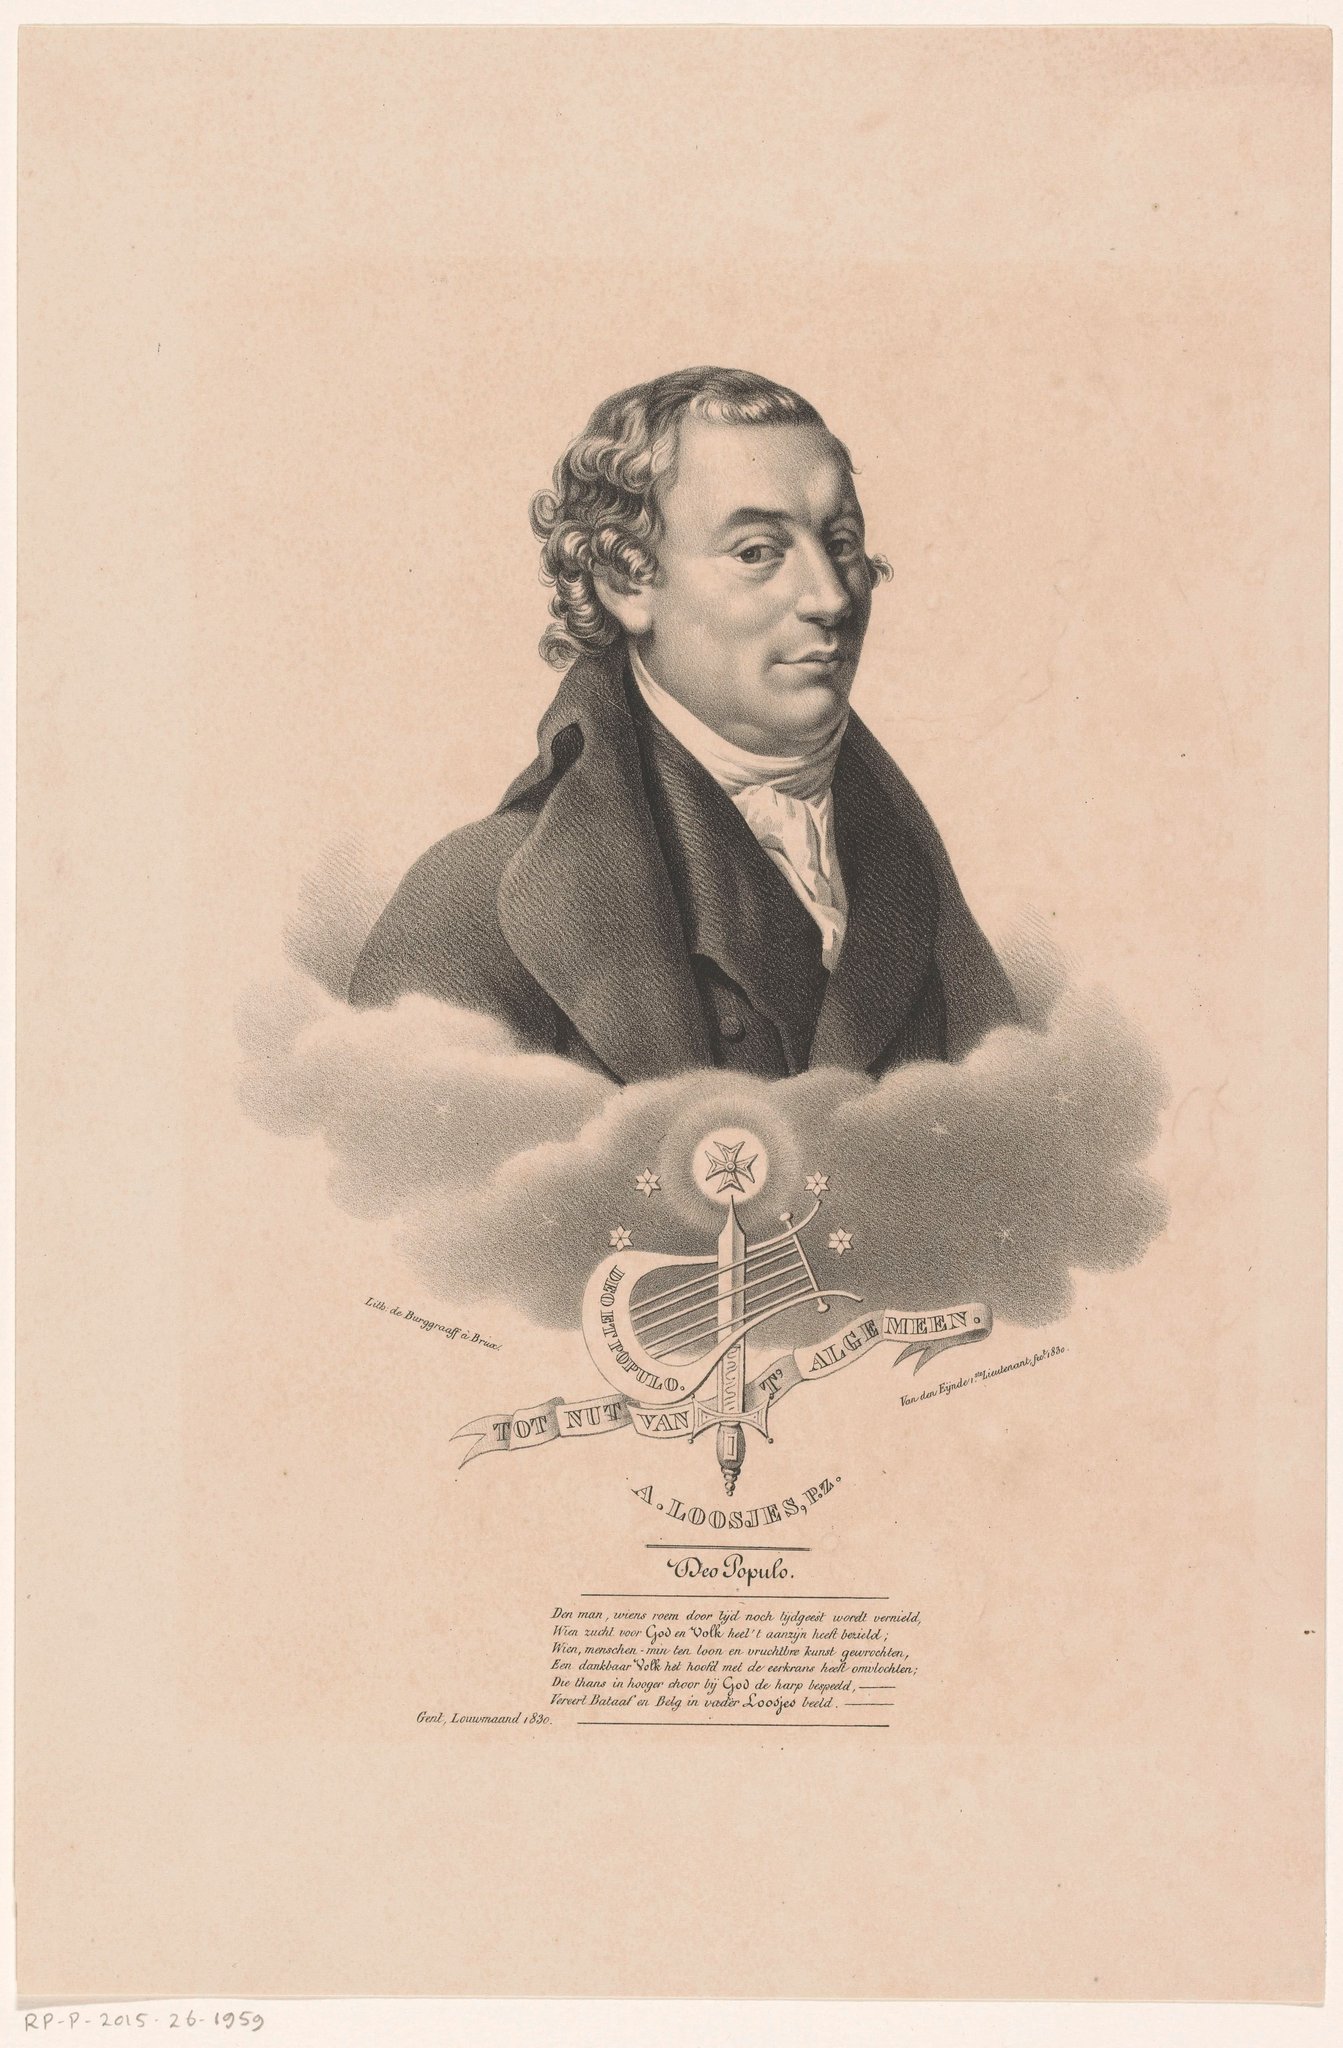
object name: print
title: Portret van Adriaan Pietersz. Loosjes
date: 1830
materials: paper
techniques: lithograph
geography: brussels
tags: haarlem, publisher, bookseller, adriaan pietersz. loosjes, hacking and thrusting weapons: sword, harp, historical persons (+ (full) bust portrait)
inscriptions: collector's mark: Lugt 4780, collector's mark: Lugt 2228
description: De geportretteerde is in een wolkenpartij met sterren afgebeeld. Hij is naar rechts gewend. Onder het portret een zwaard met een kruis, een harp met de woorden 'Deo et Populo' en een lint met de woorden: 'Tot nut van 't Algemeen.' Daaronder de naam van de geportretteerde en een zesregelig onderschrift.